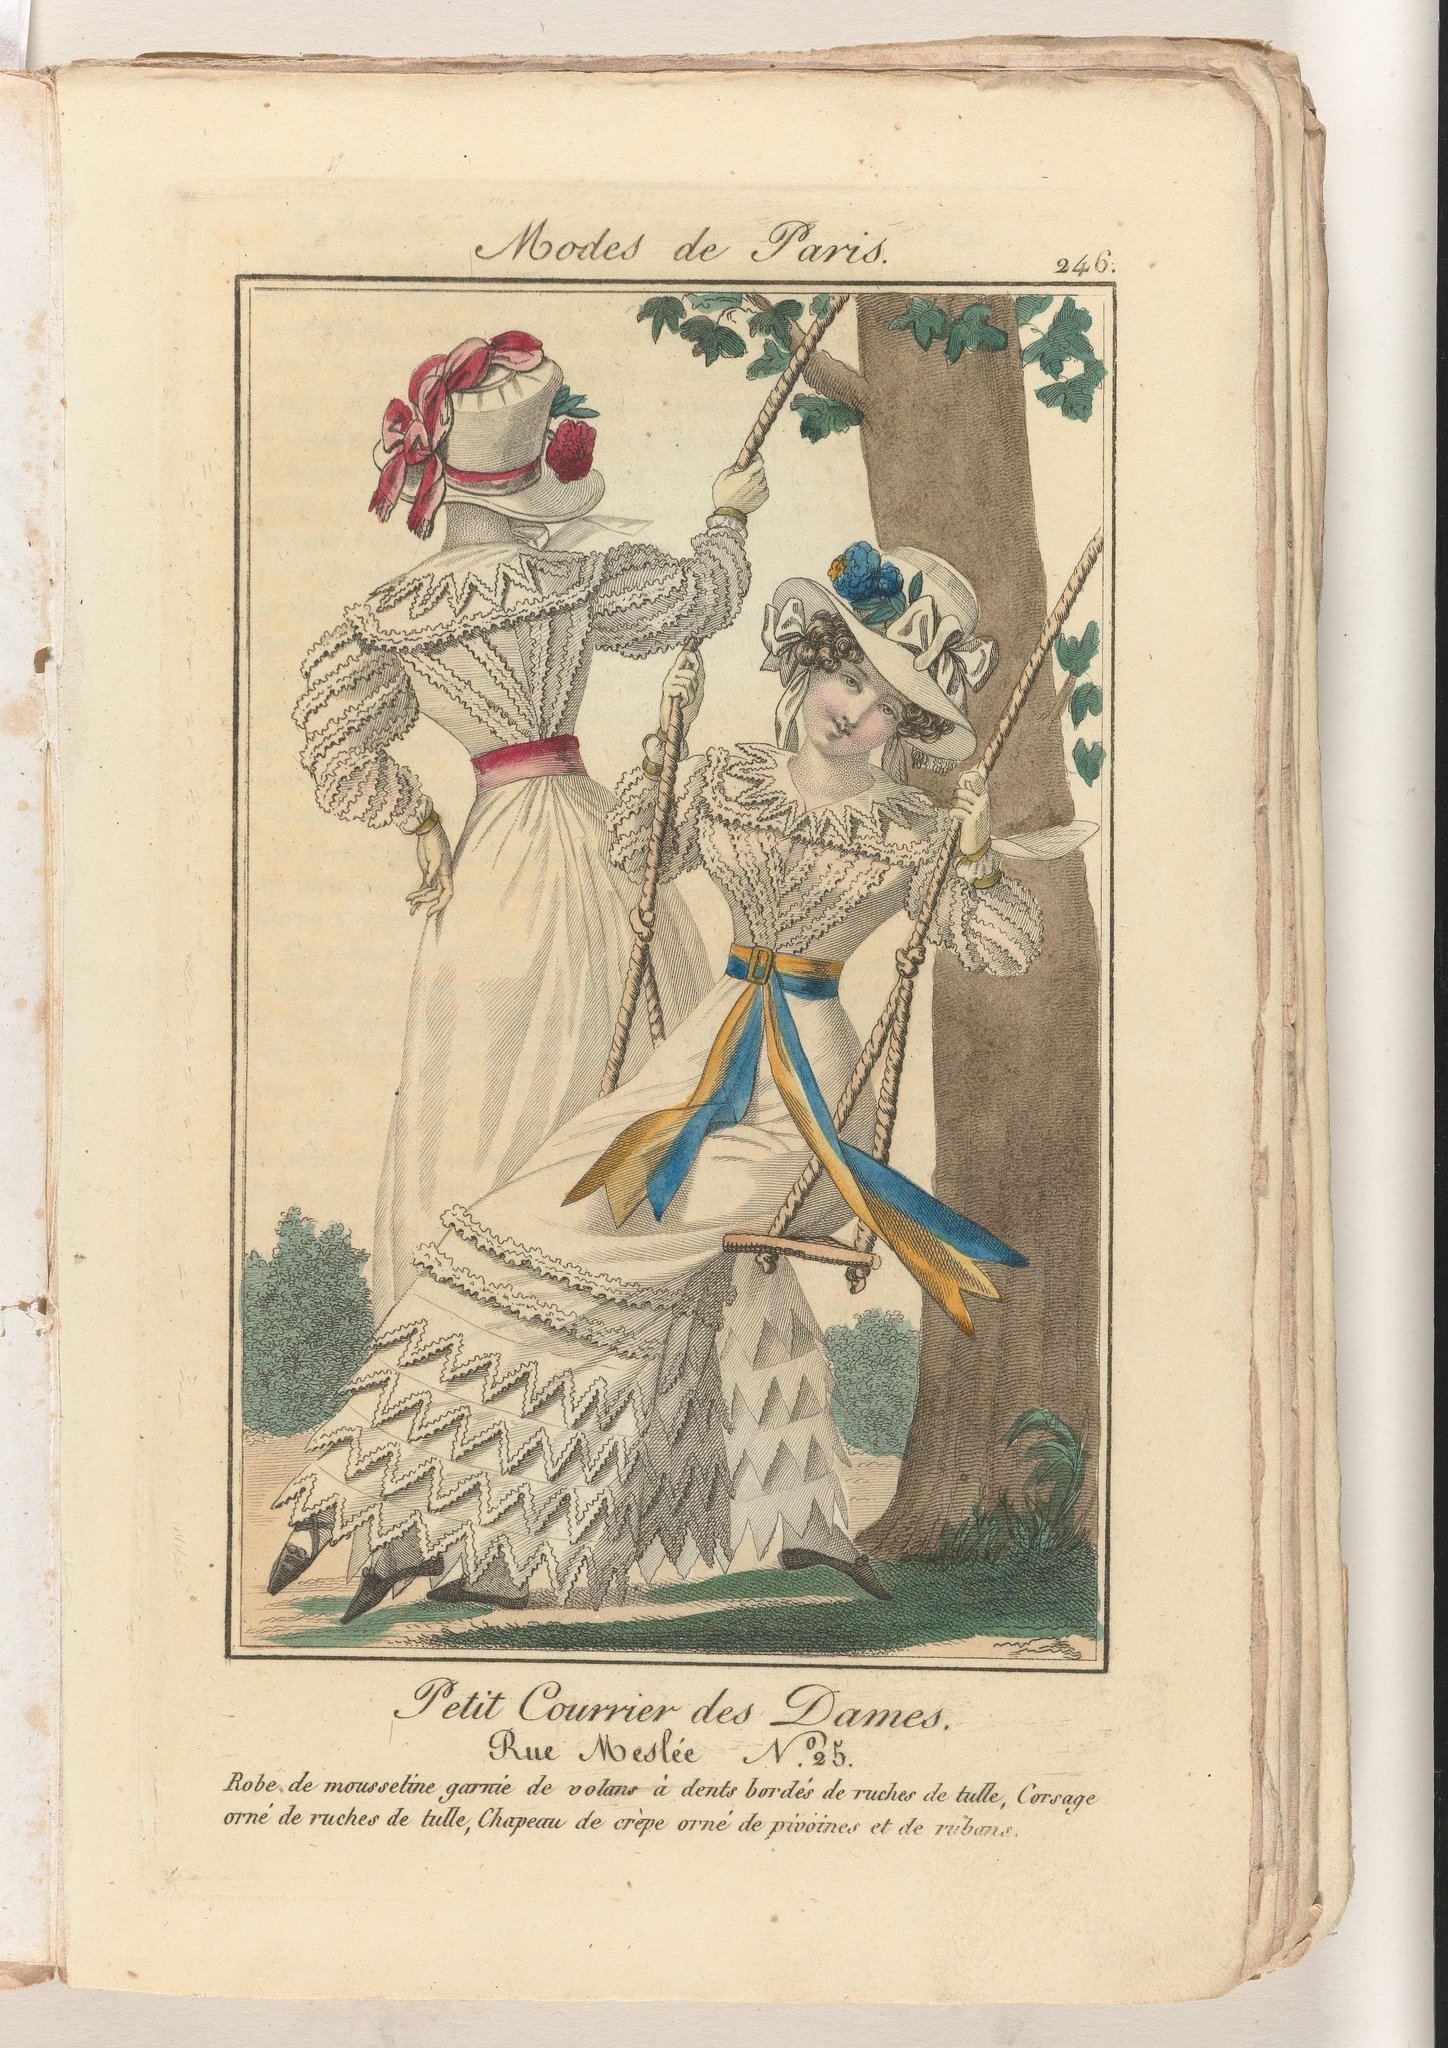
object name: magazine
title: Petit Courrier des Dames 1824 (245)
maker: Anonymous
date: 1824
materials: paper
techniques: engraving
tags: fashion plates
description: Prent uit het modetijdschrift Petit Courrier des Dames (1821-1868).